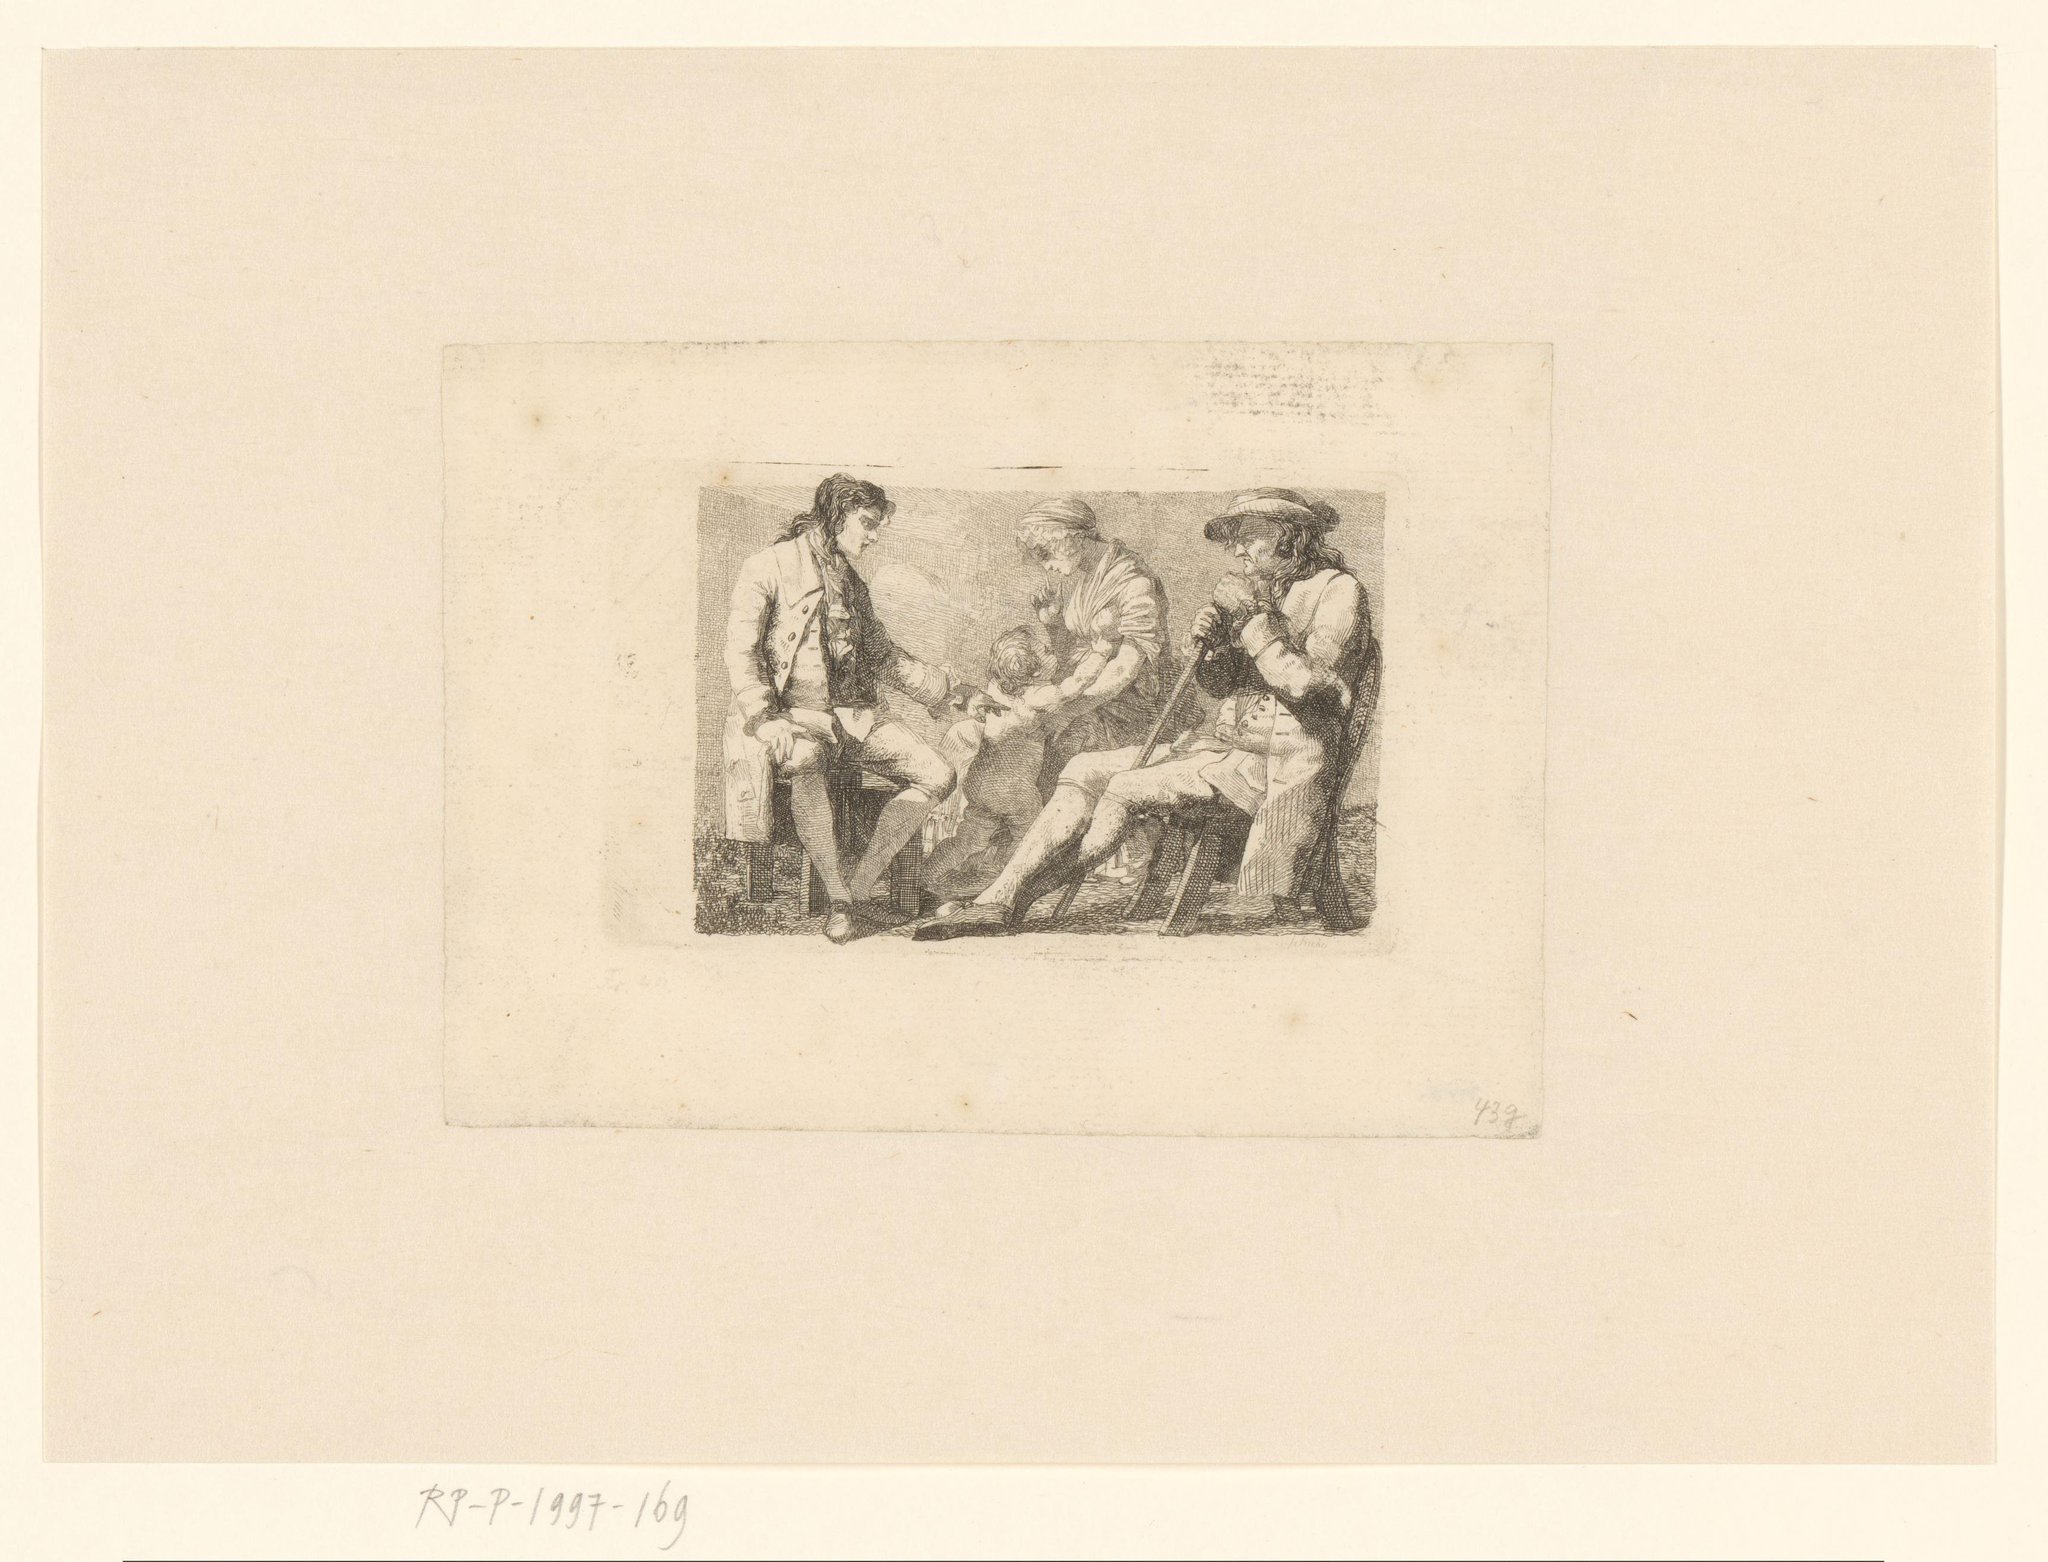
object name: print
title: Familiegroep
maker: gottfried schadow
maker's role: print maker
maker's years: 1764-1850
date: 1784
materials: paper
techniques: etching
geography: germany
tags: family group, especially parents with their child(ren)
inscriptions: collector's mark: Lugt 2228